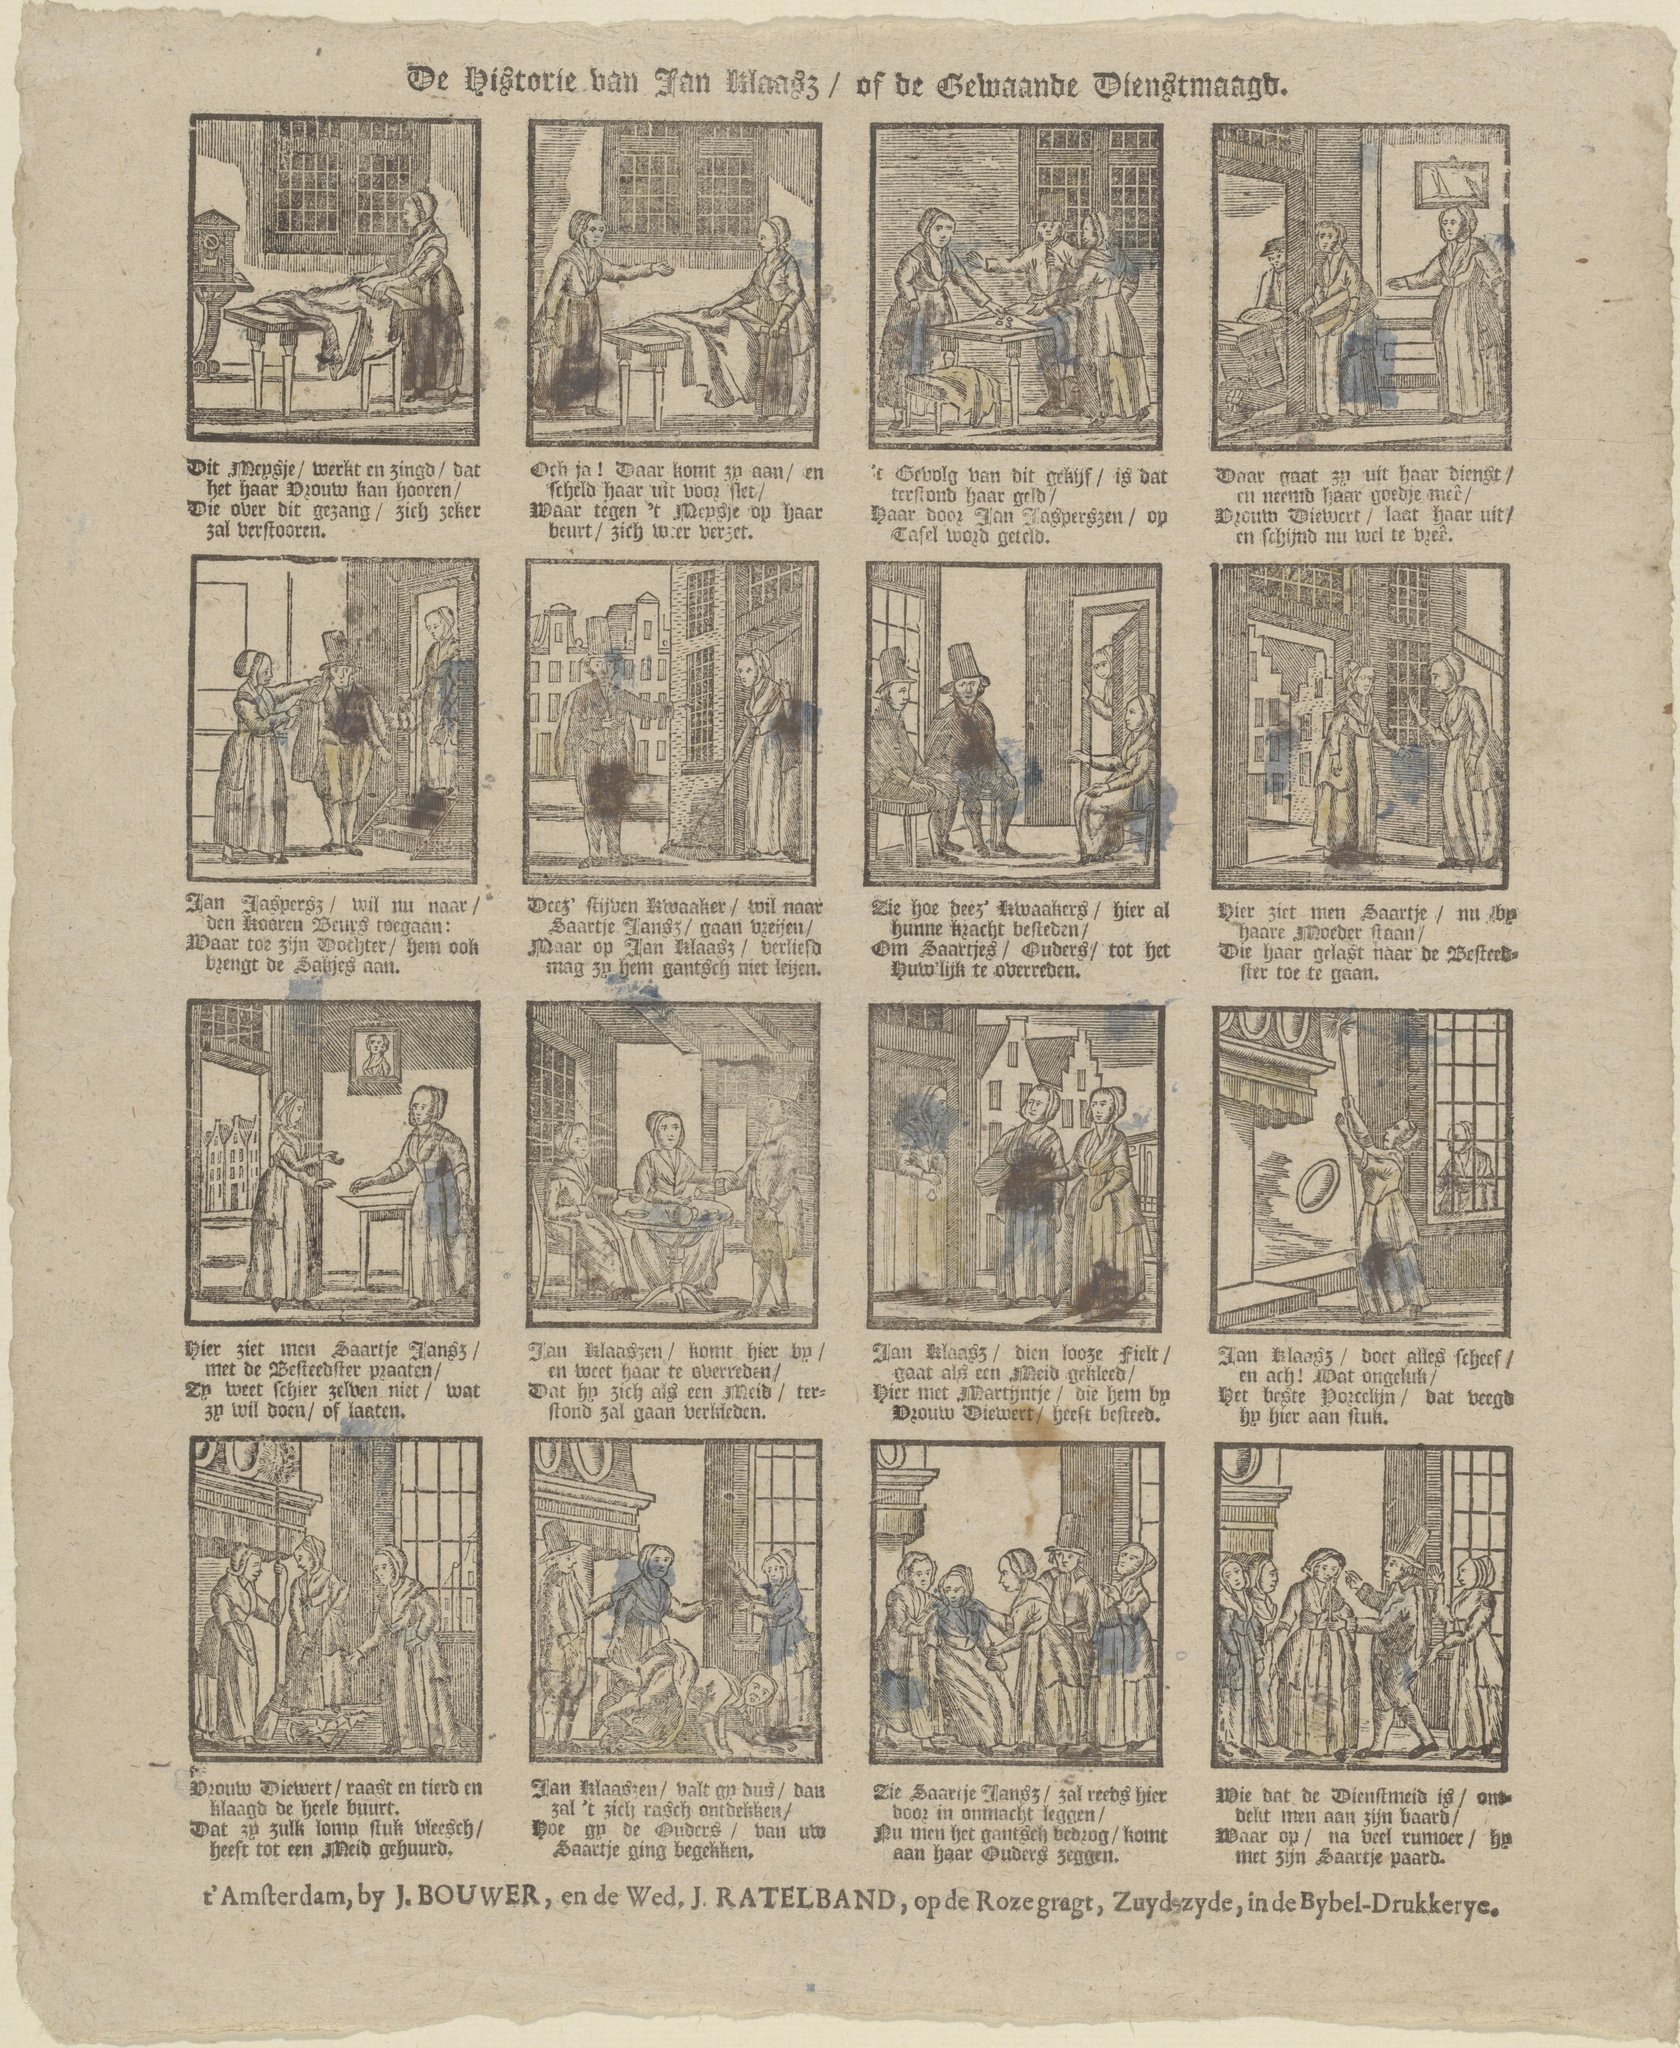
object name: popular print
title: De historie van Jan Klaasz / of de gewaande dienstmaagd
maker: Anonymous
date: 1794-1804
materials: paper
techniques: colour, letterpress printing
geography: netherlands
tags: man dressed as woman, travesty, maid ~ house personnel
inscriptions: collector's mark: Lugt 2760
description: Blad met 16 voorstellingen over Jan Klaassen die zich voordoet als een dienstmeid. Onder elke afbeelding een vers.